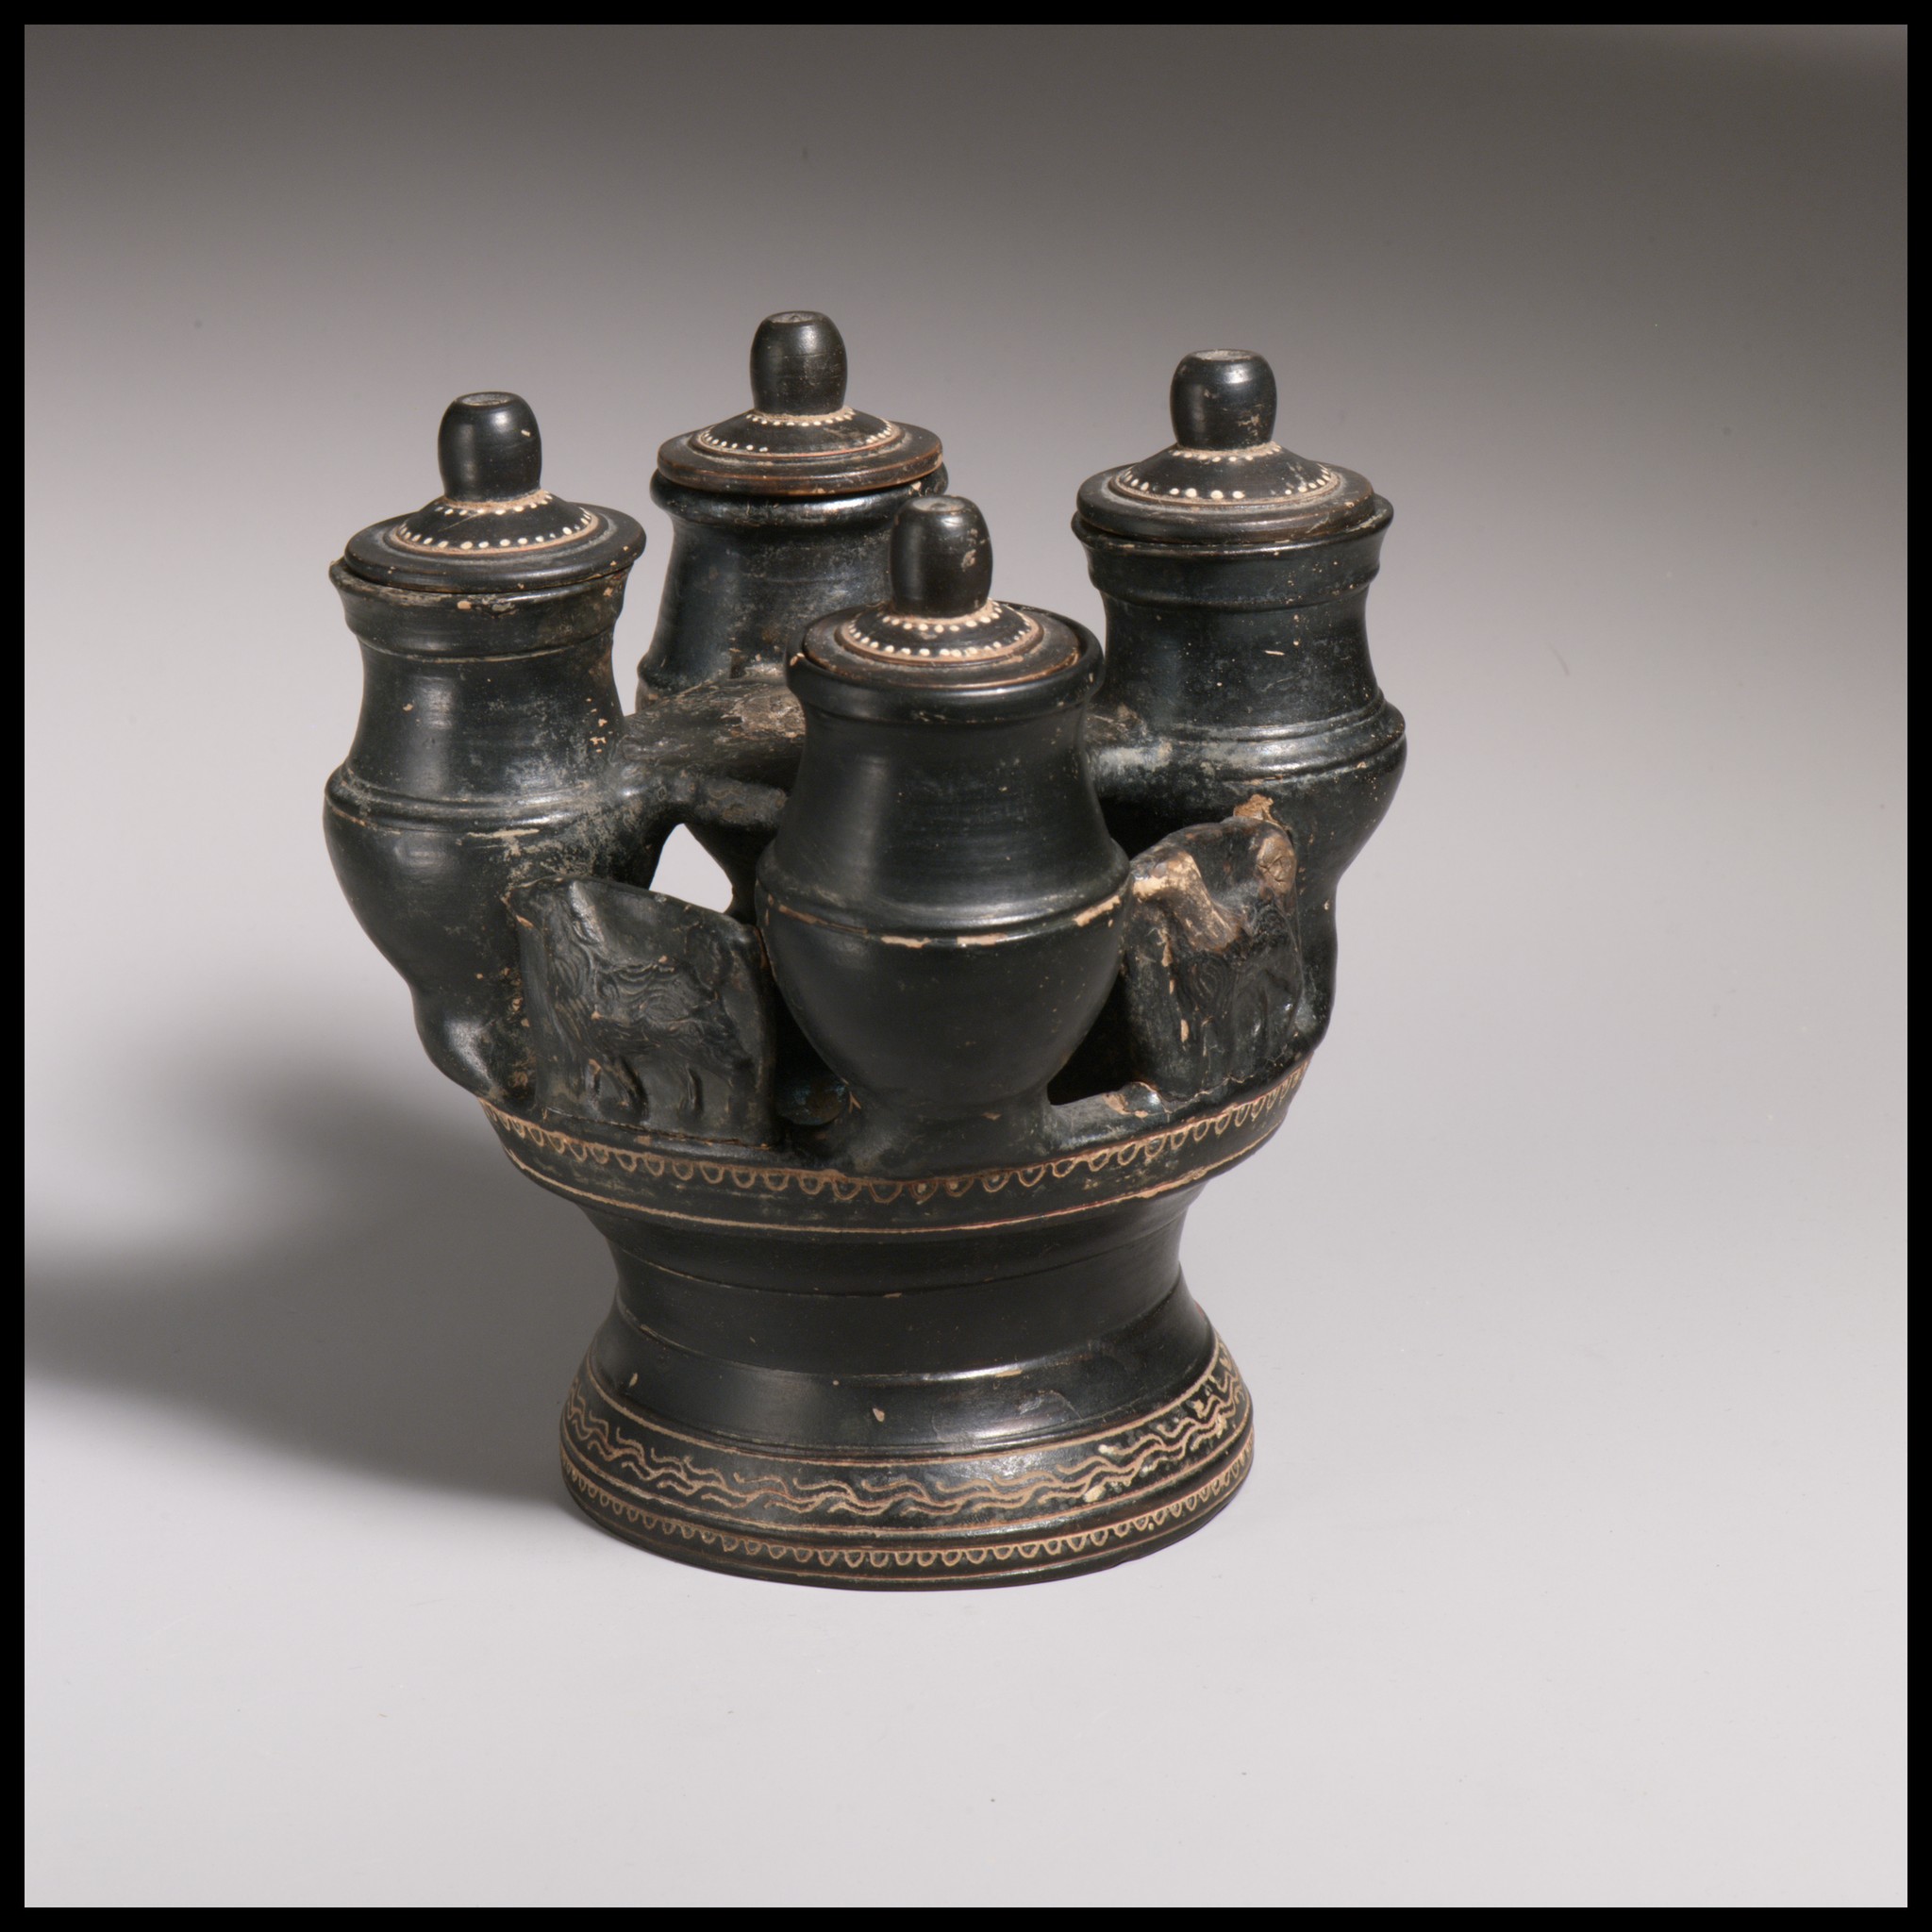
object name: kernos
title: Terracotta kernos (vase for multiple offerings)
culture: greek or south italian or campanian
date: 330-300 BCE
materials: terracotta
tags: dogs